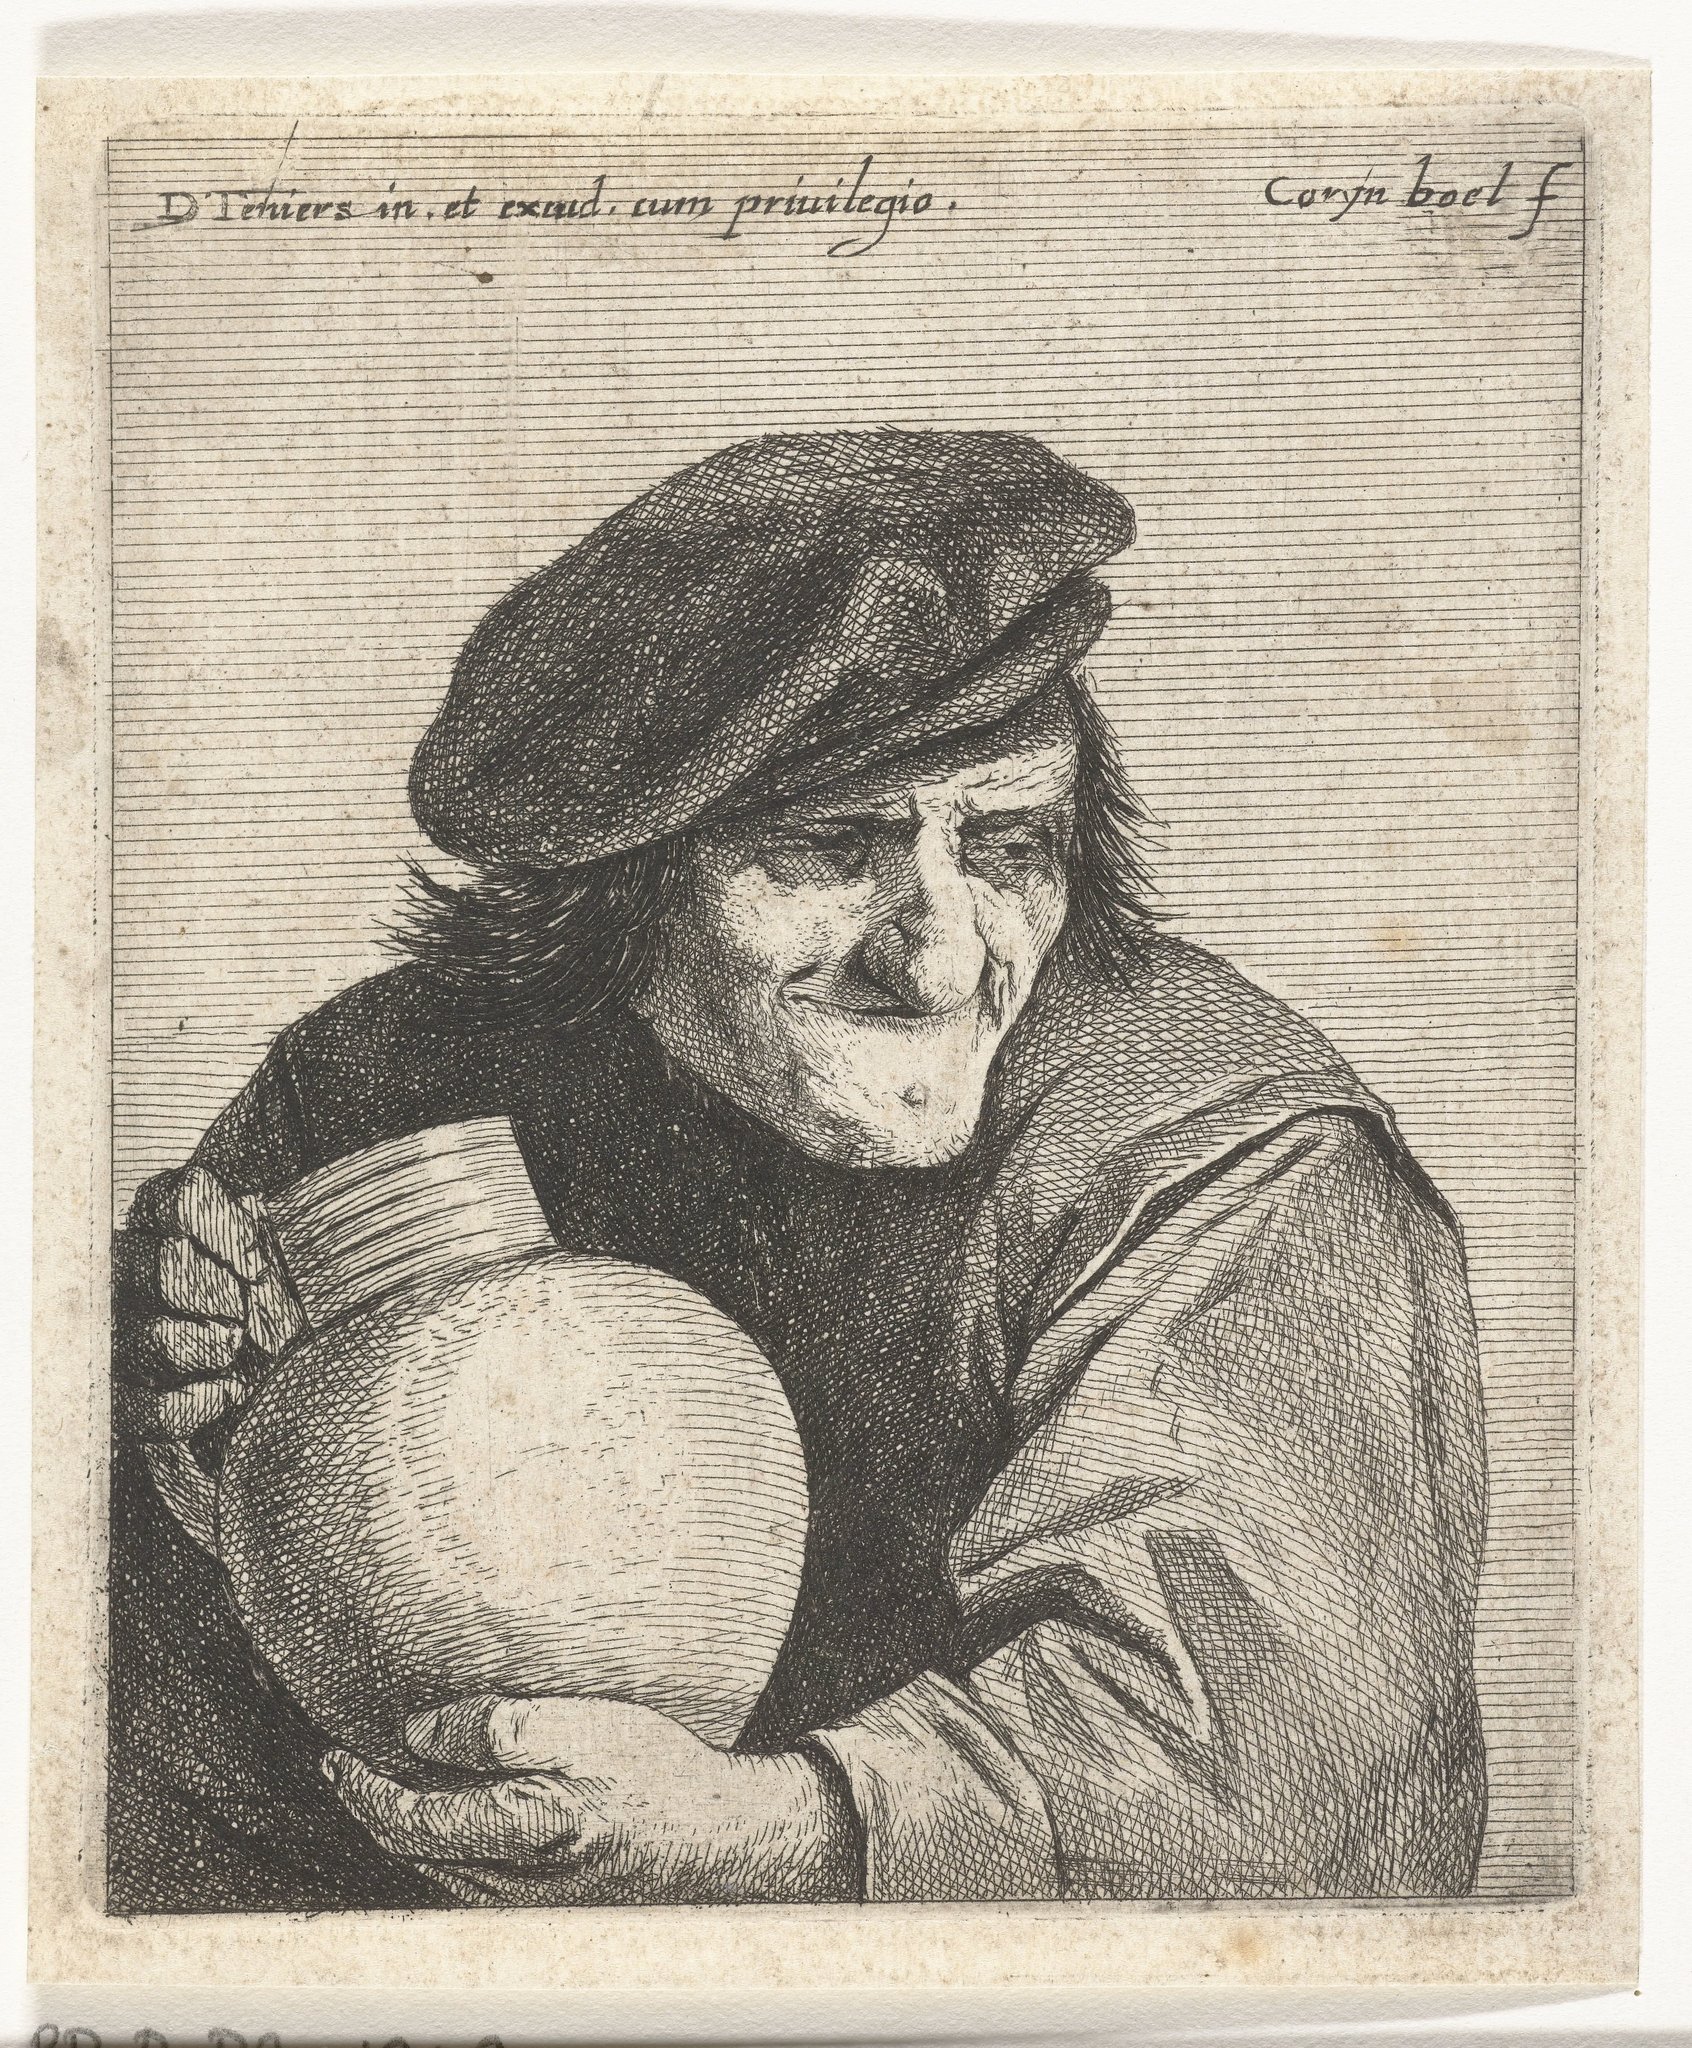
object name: print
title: Boer met kan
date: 1635-1690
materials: paper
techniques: etching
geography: southern netherlands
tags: adult man (+ three-quarter view)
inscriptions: collector's mark: Lugt 240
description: Een kneuterige boer met een pet op en een kan in zijn handen.